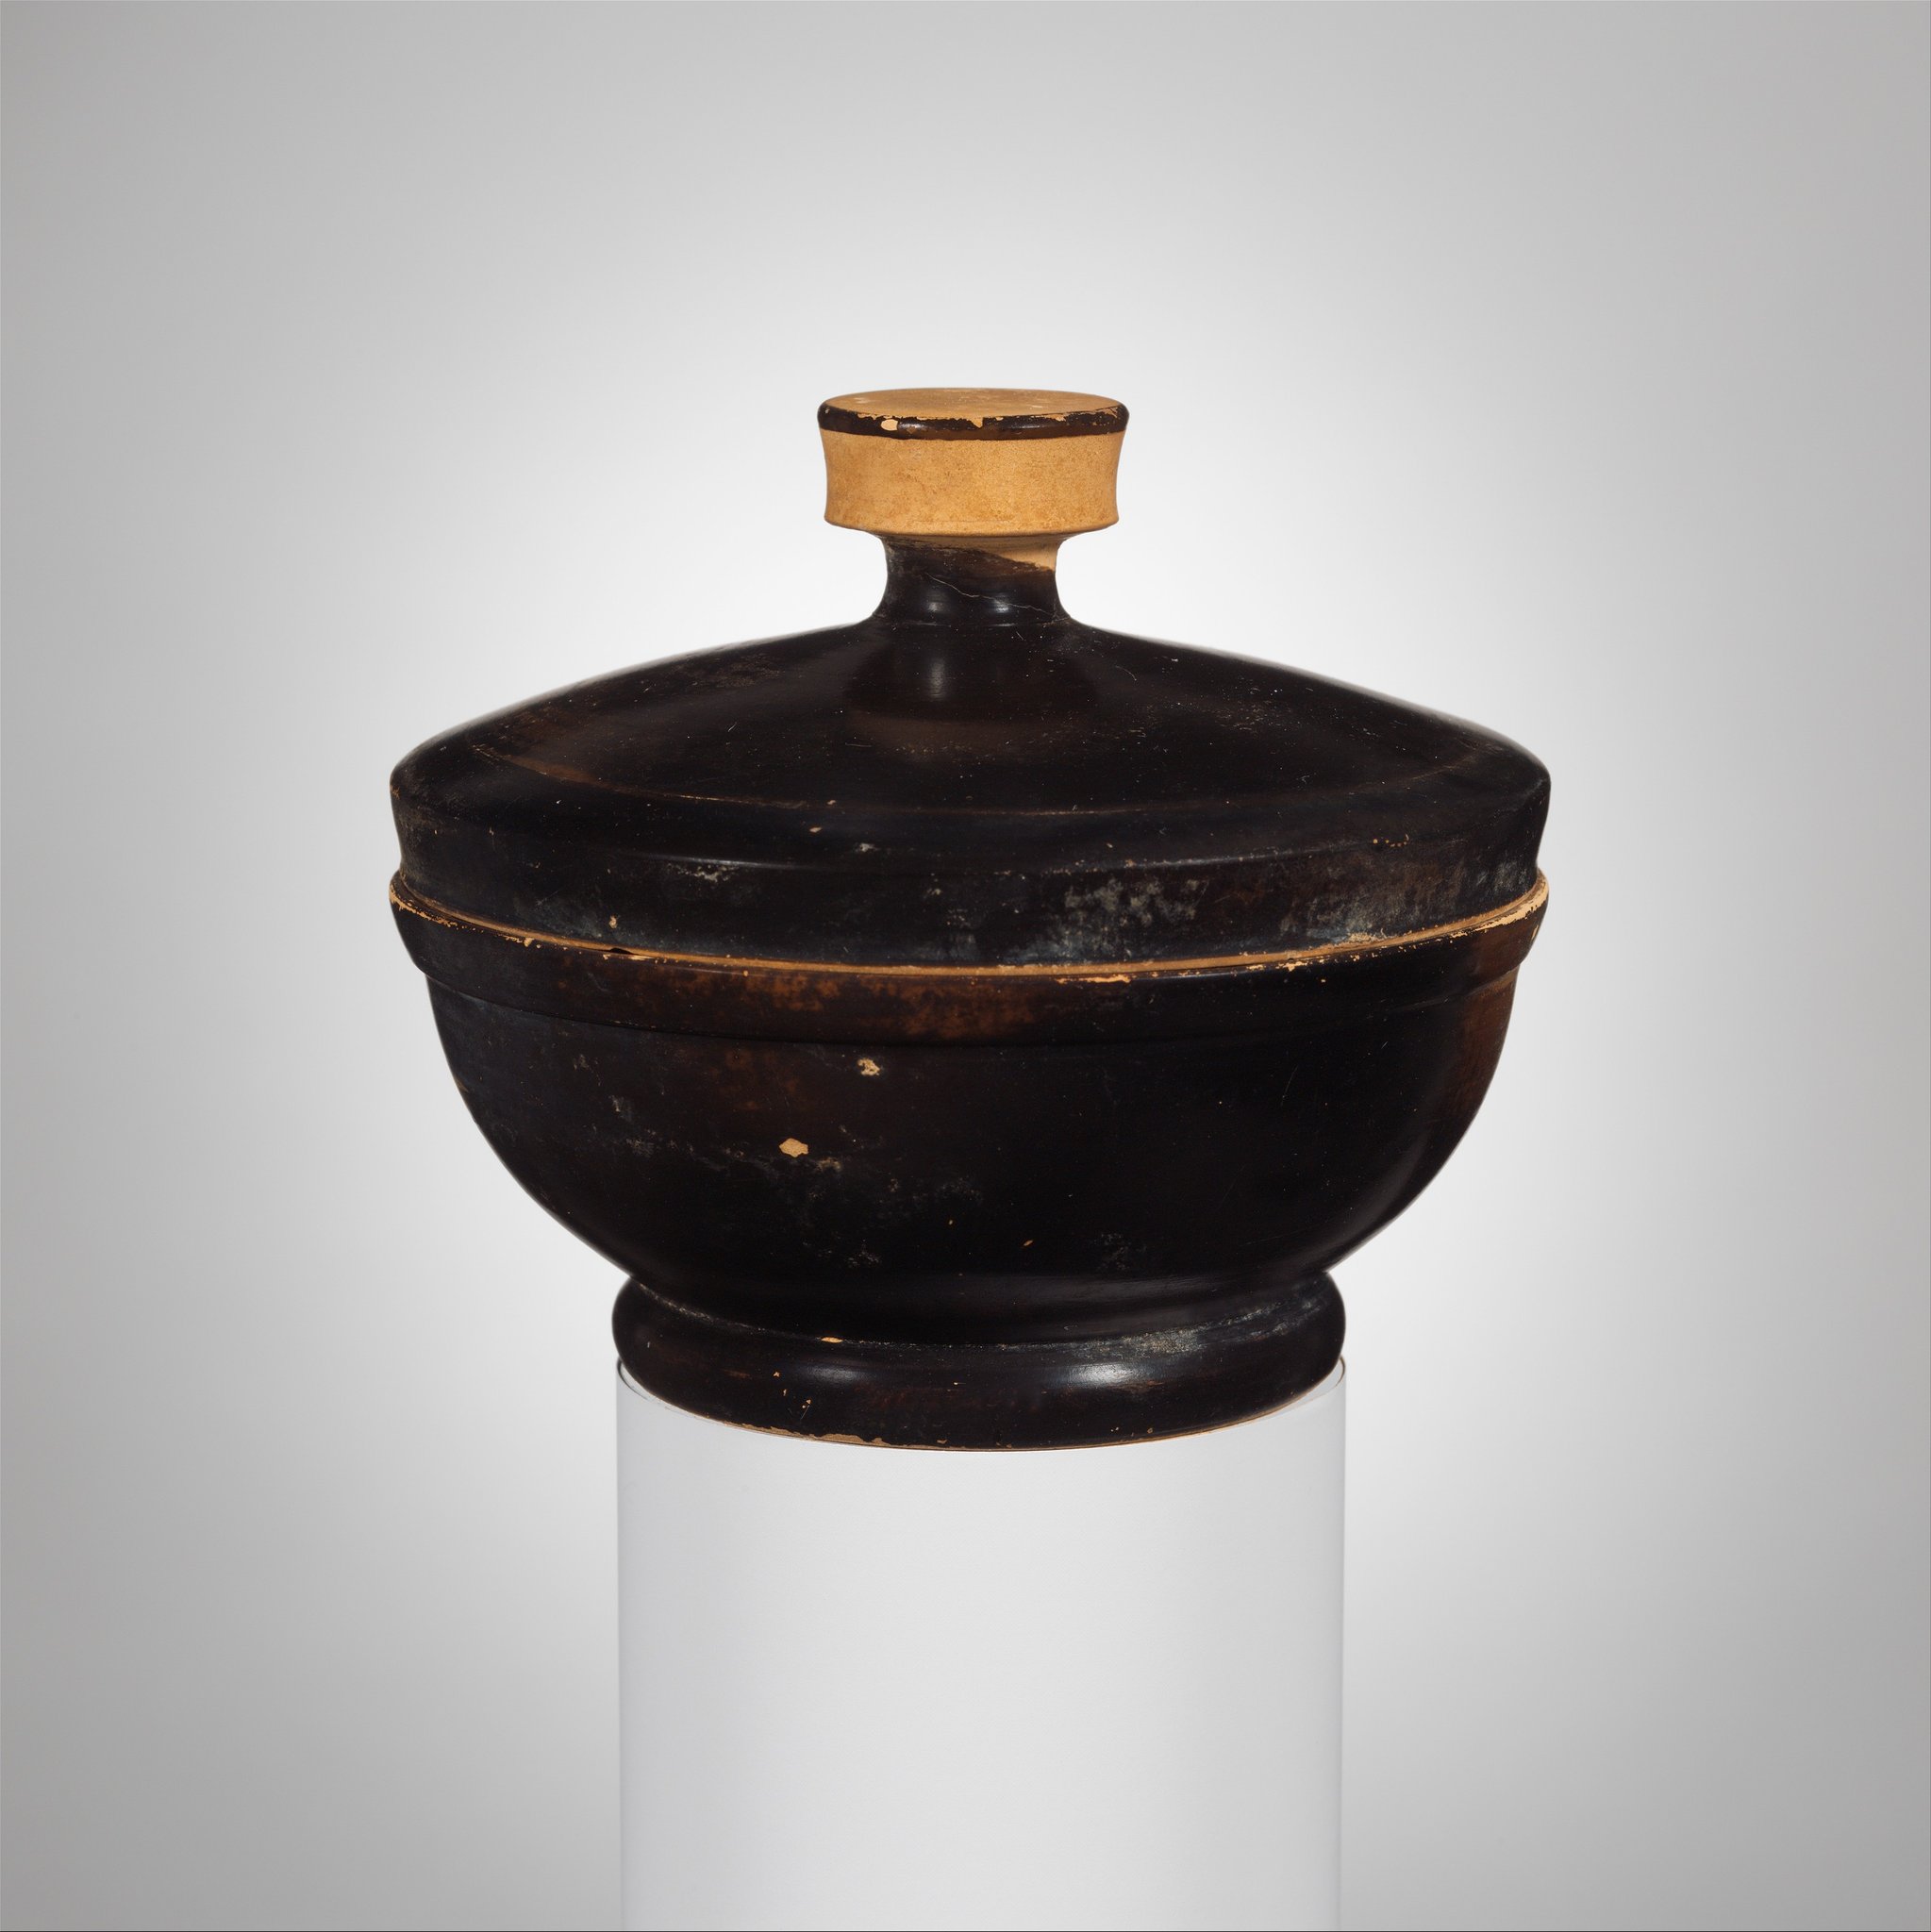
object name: lekane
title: Terracotta covered bowl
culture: greek, attic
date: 450-400 BCE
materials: terracotta